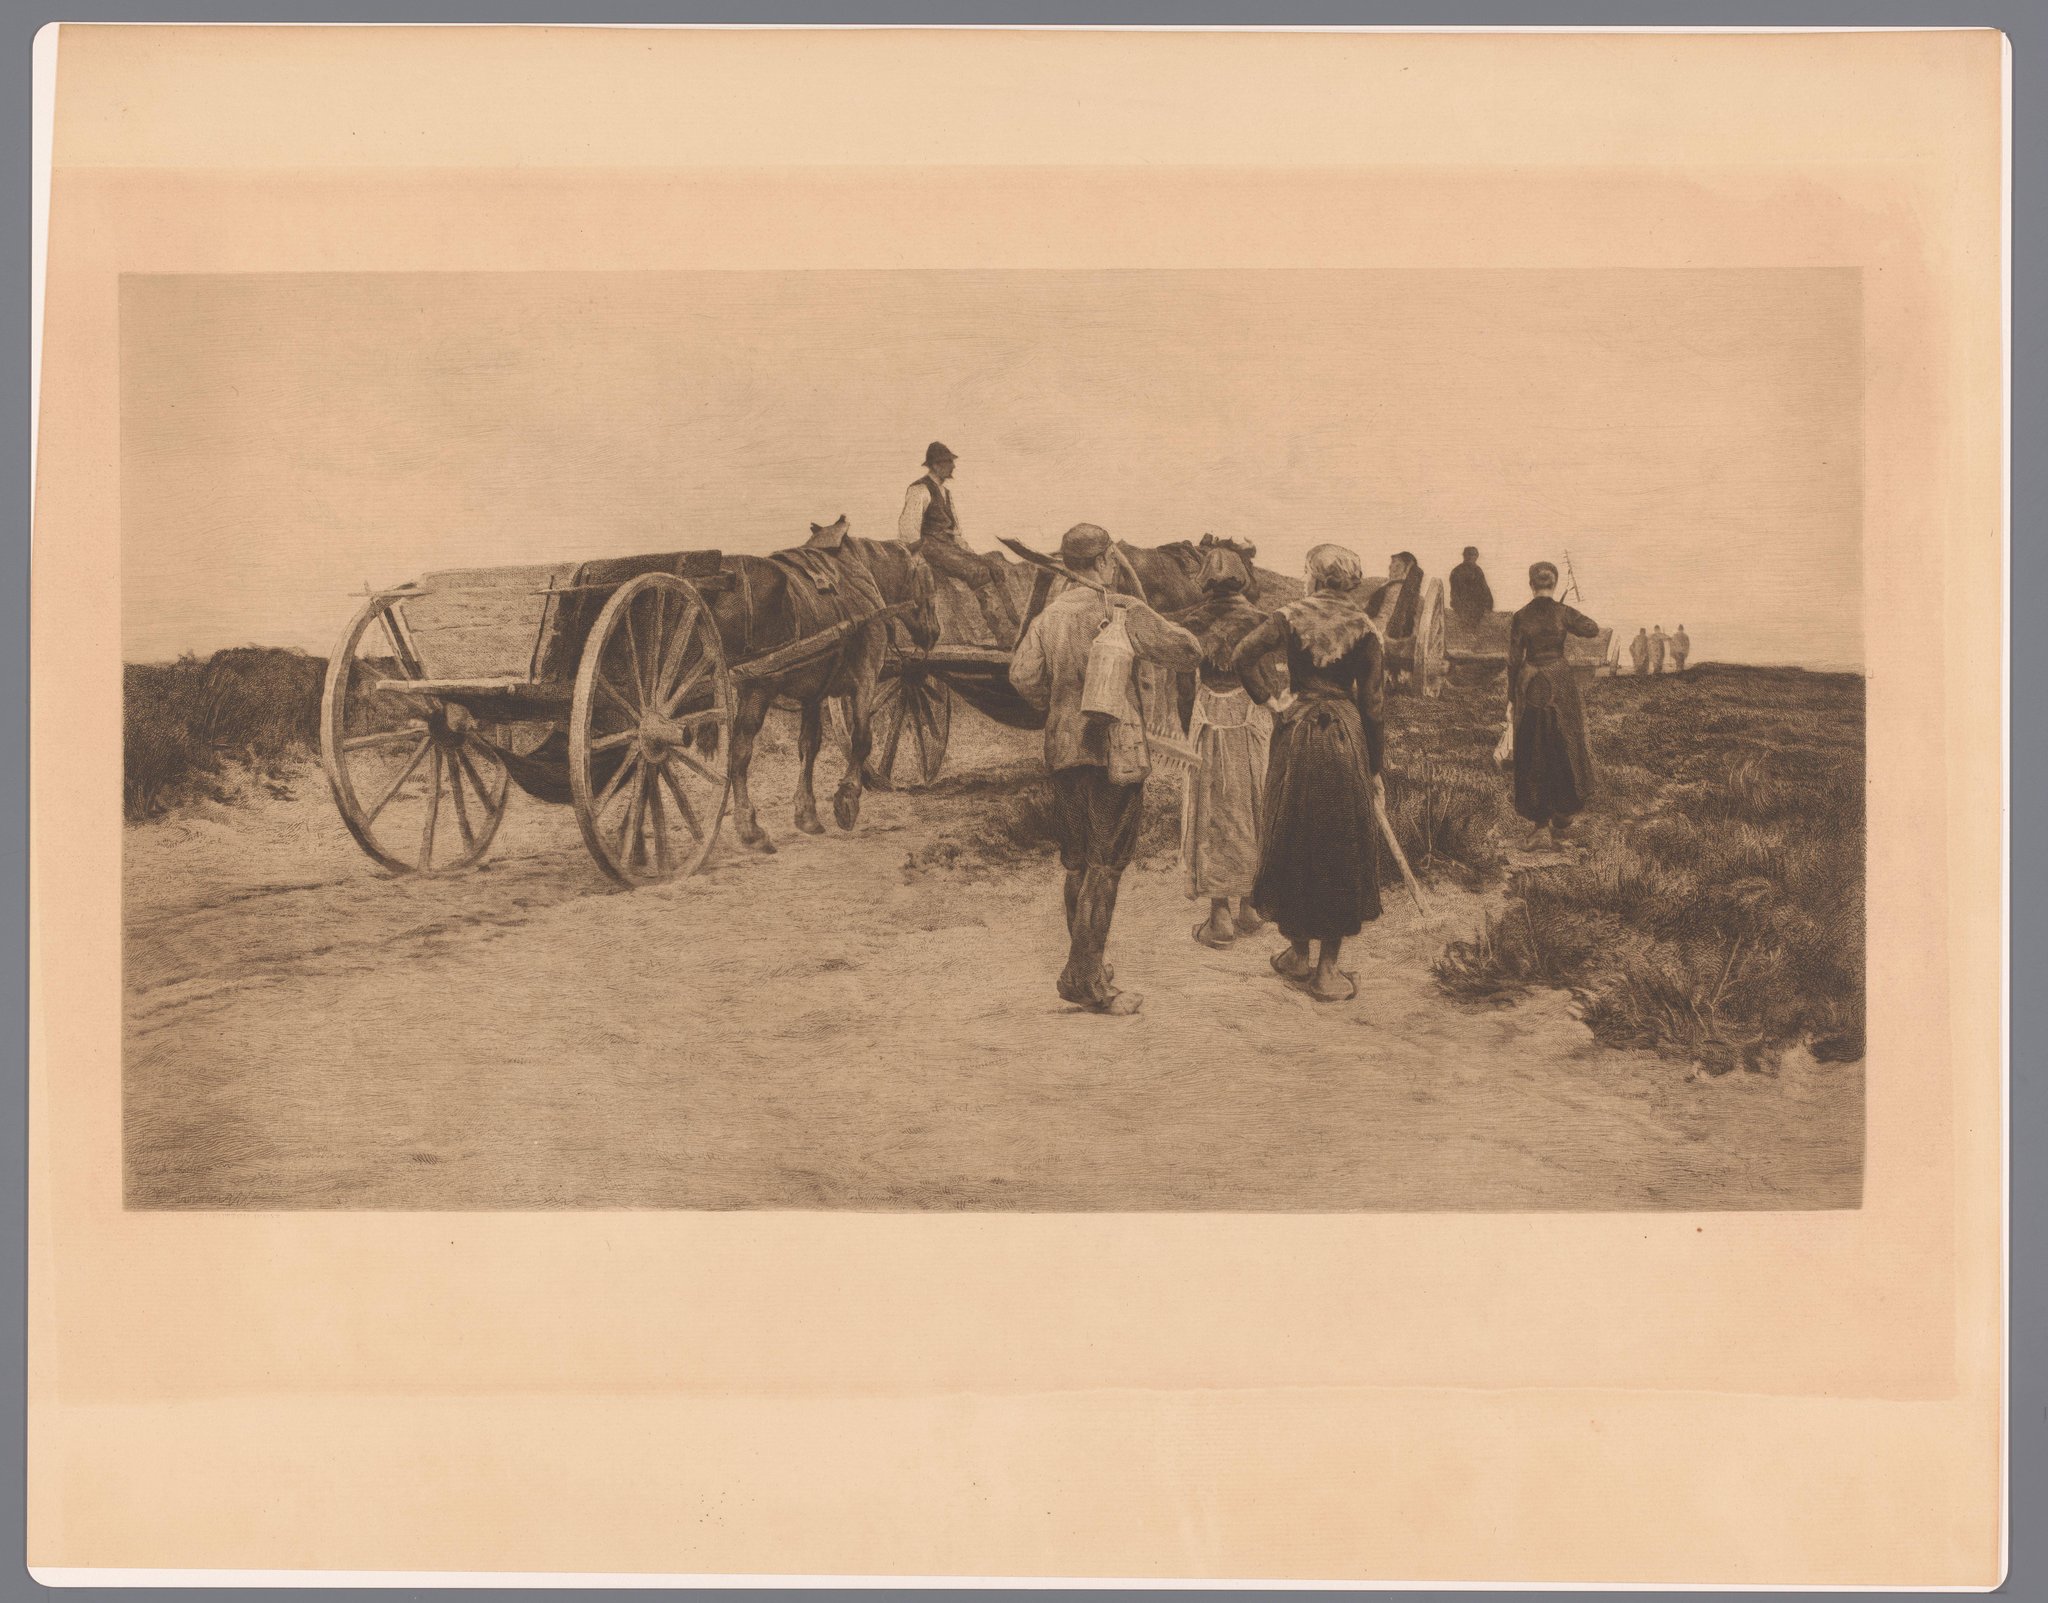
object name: print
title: Landarbeiders op een pad met karren en gereedschap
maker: frans lauwers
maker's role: print maker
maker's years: 1854-1931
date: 1887-1914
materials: paper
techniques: etching, intaglio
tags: farmers, (farm) wagon, freight wagon, cart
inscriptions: collector's mark: Lugt 2228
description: Het schilderij waarop deze prent gebaseerd is (Veenland van Postel) bevindt zich in het Koninklijk Museum voor Schone Kunsten te Brussel.